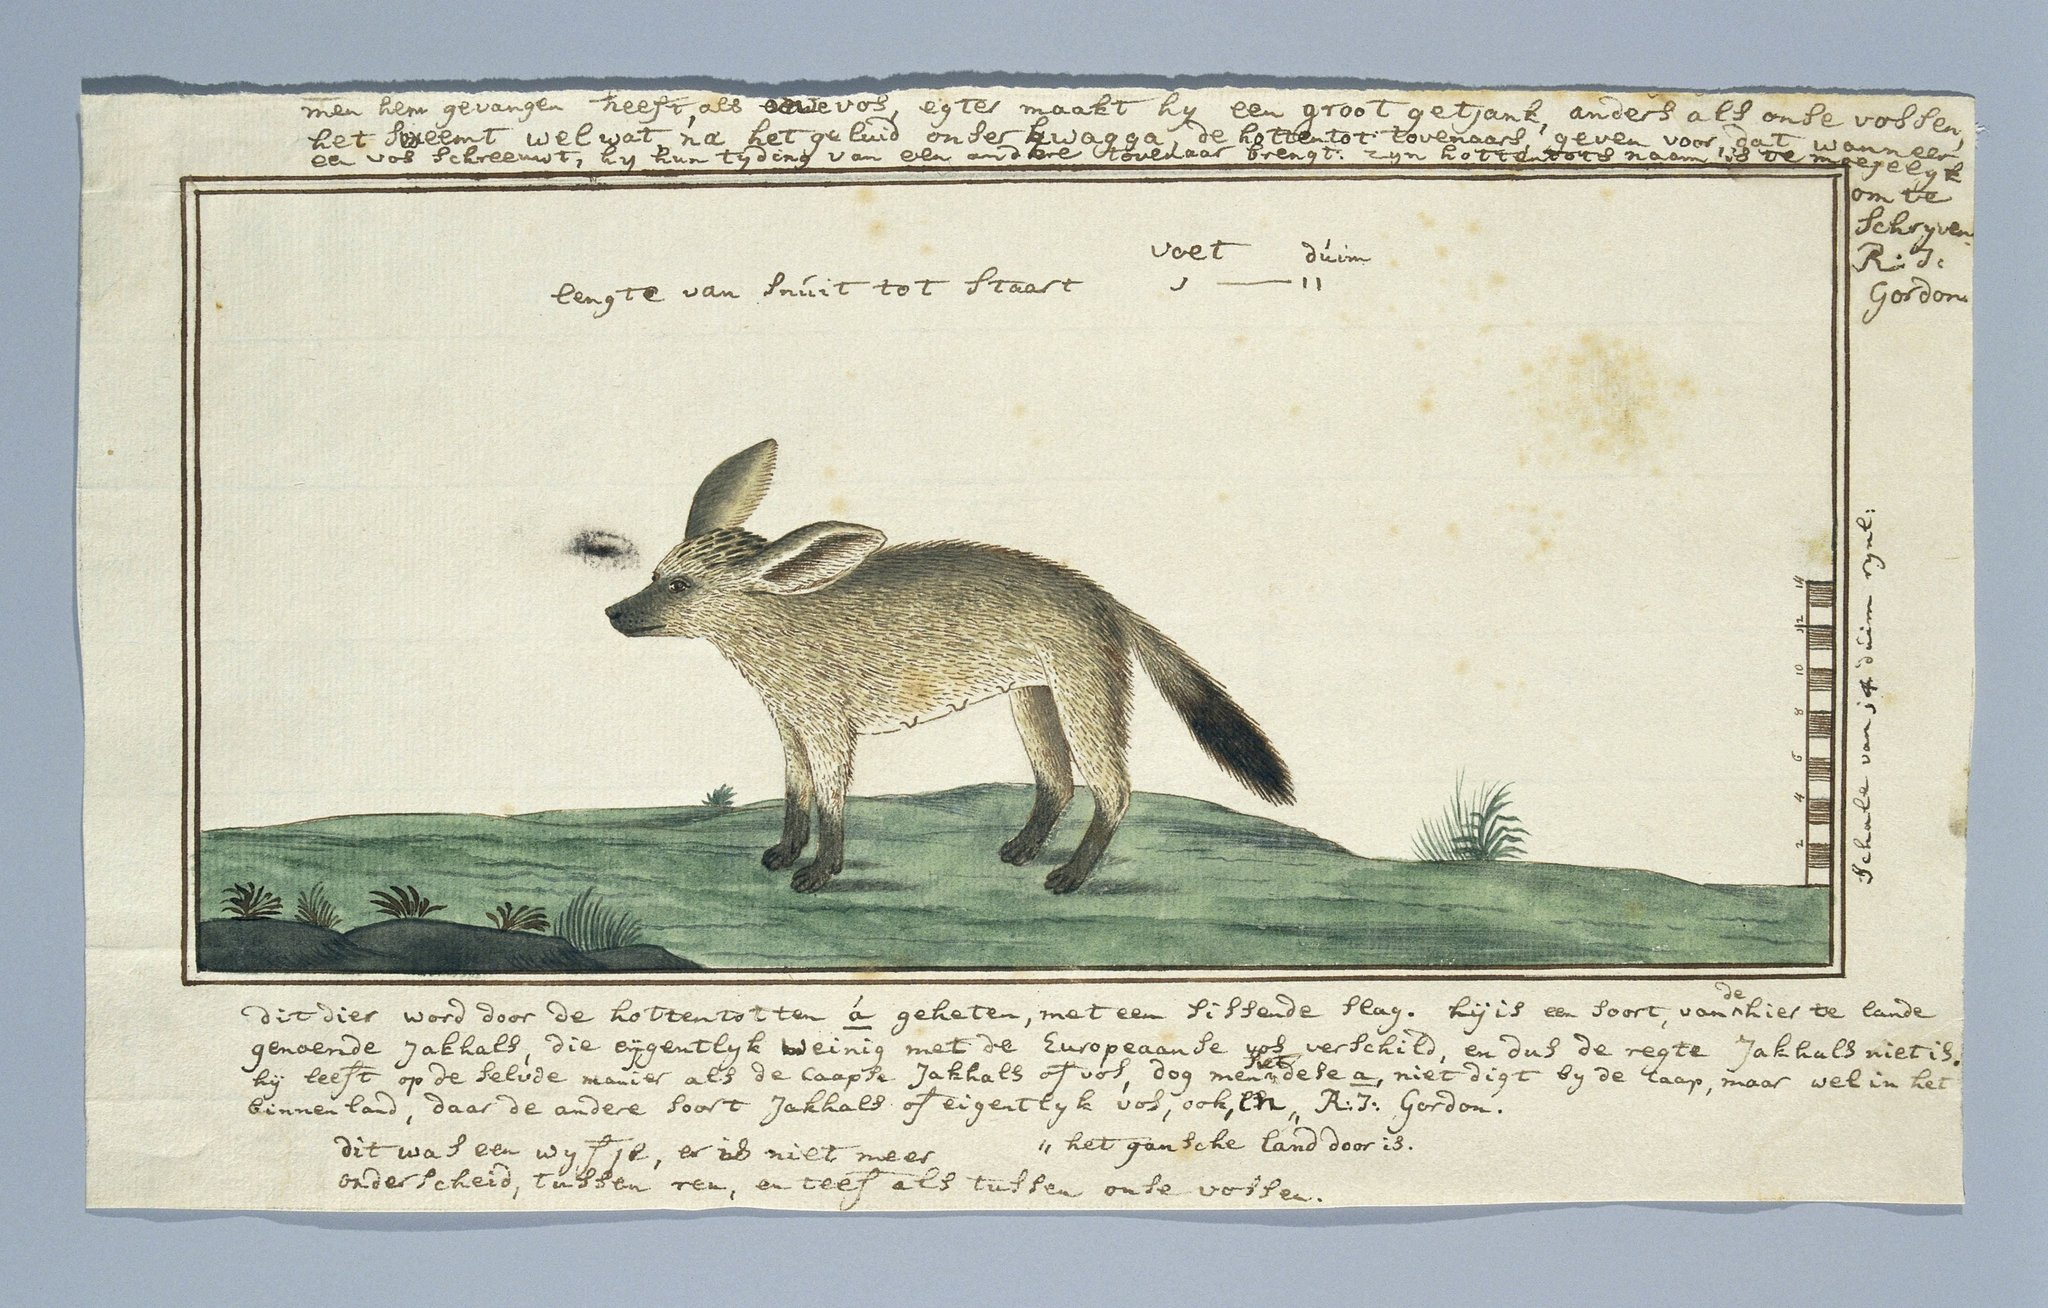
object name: album leaf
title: Otocyon megalotis (Bat-eared fox; female)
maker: robert jacob gordon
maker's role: draughtsman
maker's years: 1743-1795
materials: ink, paper, watercolor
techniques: brush, pen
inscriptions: annotation: ‘lengte van snuit tot staart voet duim, daaronder 3 - 11; rechts naast schaalindeling, buiten kader in marge: schale van : 4 duim rijnl:’, signature: ‘R: J: Gordon’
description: Kaapse vos (Otocyon megalotis), met schaalindeling in Rijnlandse duim.